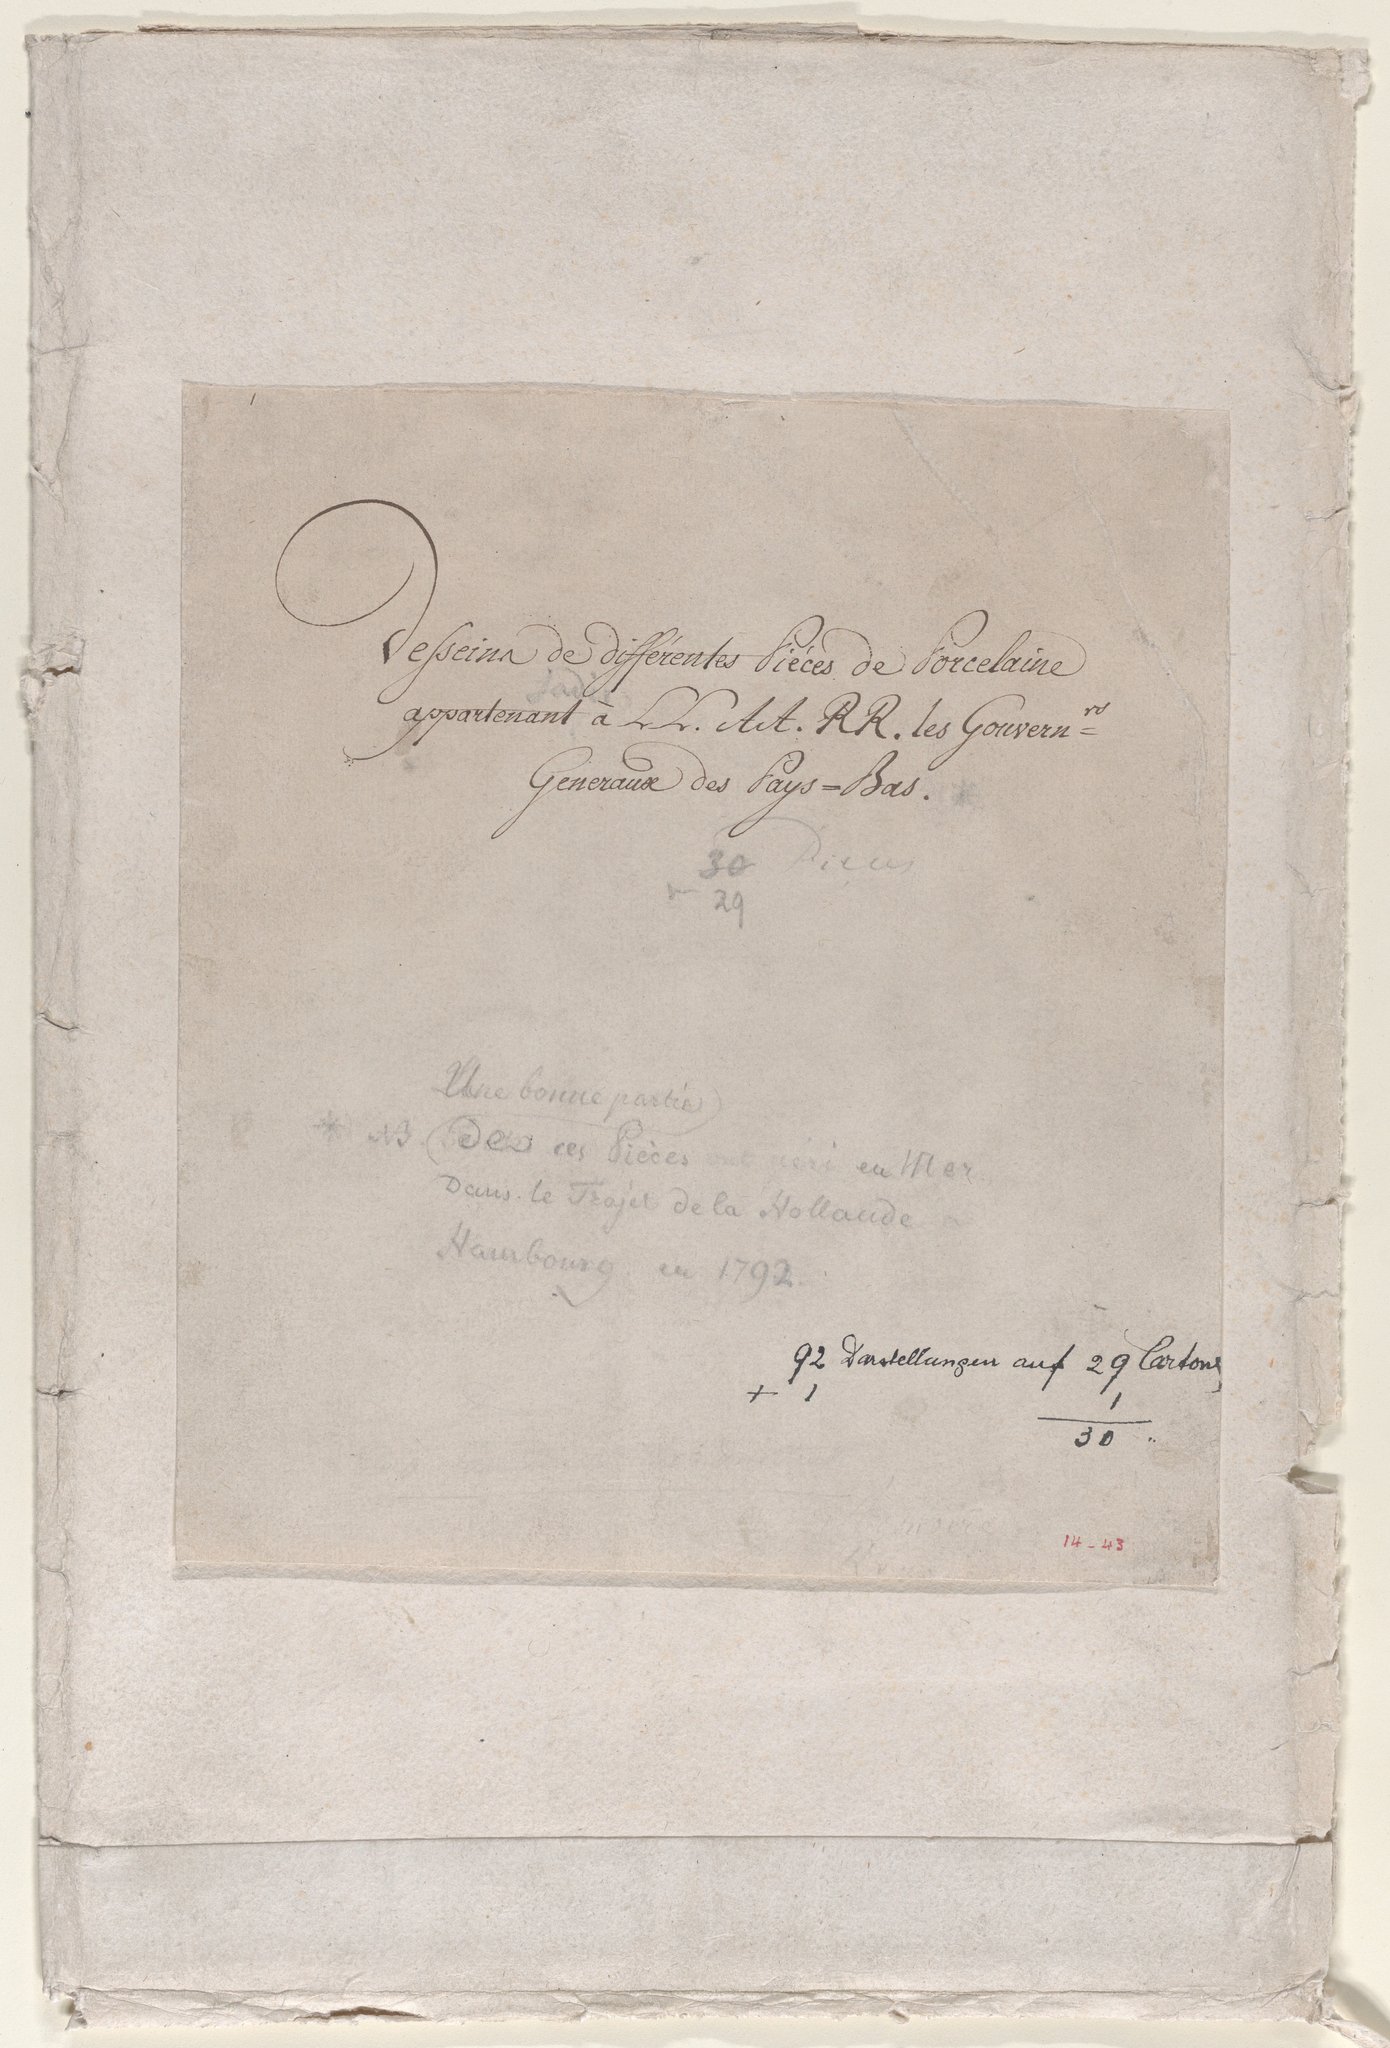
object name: drawing ornament architecture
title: Portfolio Cover for a Group of Drawings showing Porcelain Vessels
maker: anonymous, french, 18th century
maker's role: artist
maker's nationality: french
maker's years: 1700-1800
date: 1770-1785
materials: graphite, ink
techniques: pen